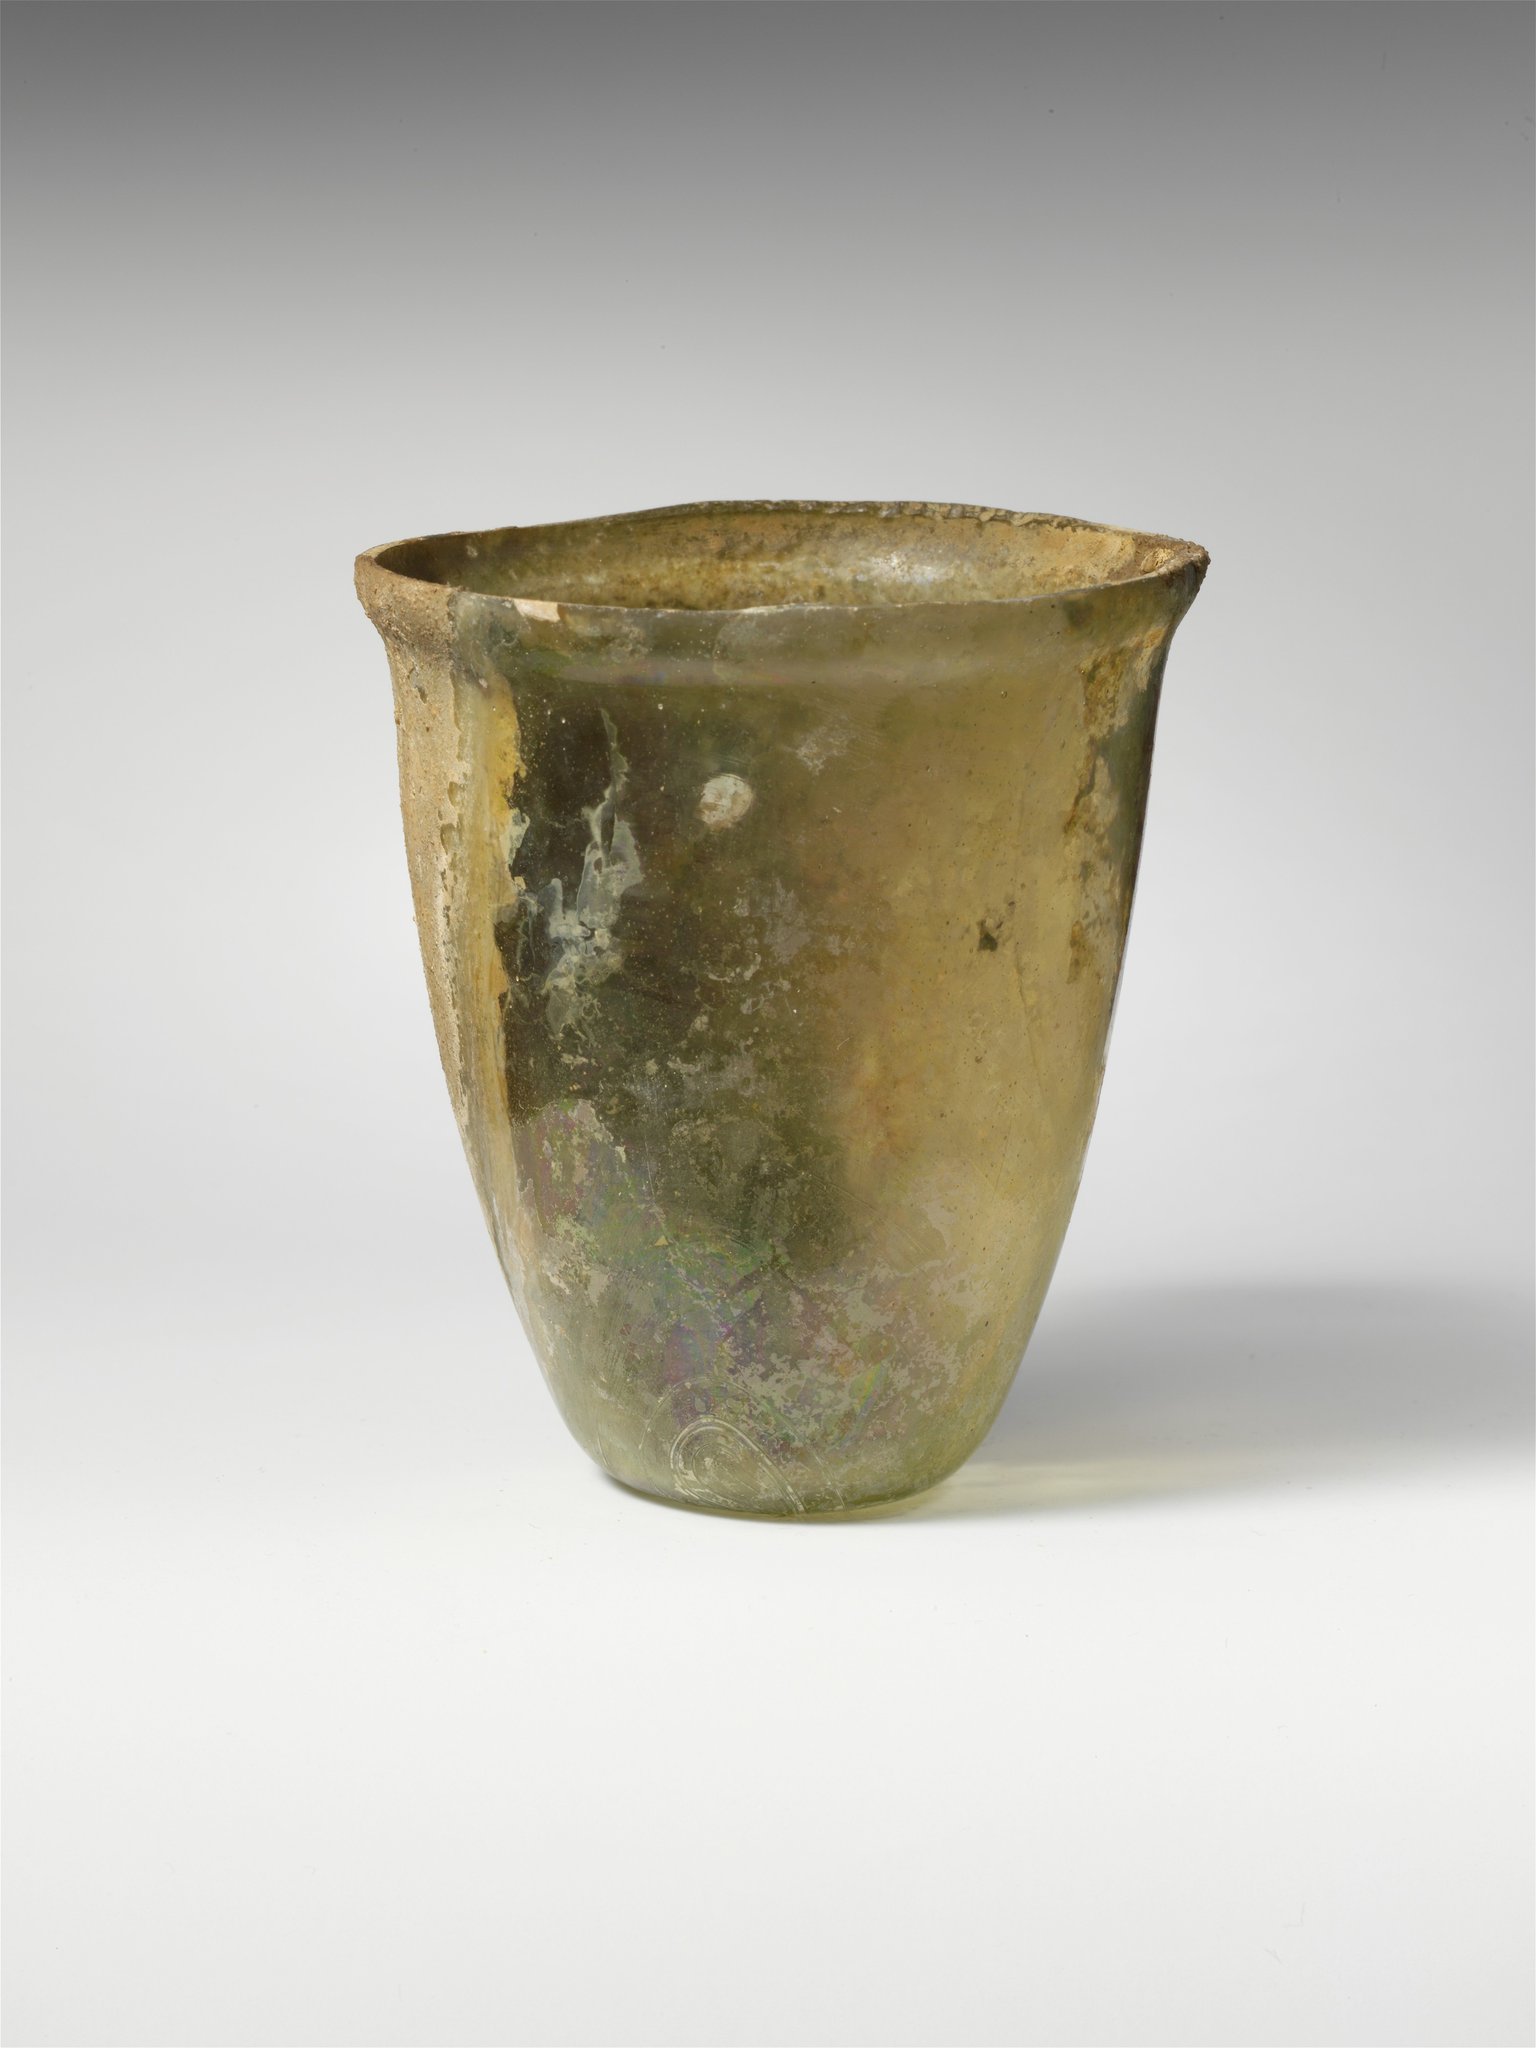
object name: beaker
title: Glass beaker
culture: roman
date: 1-100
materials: glass